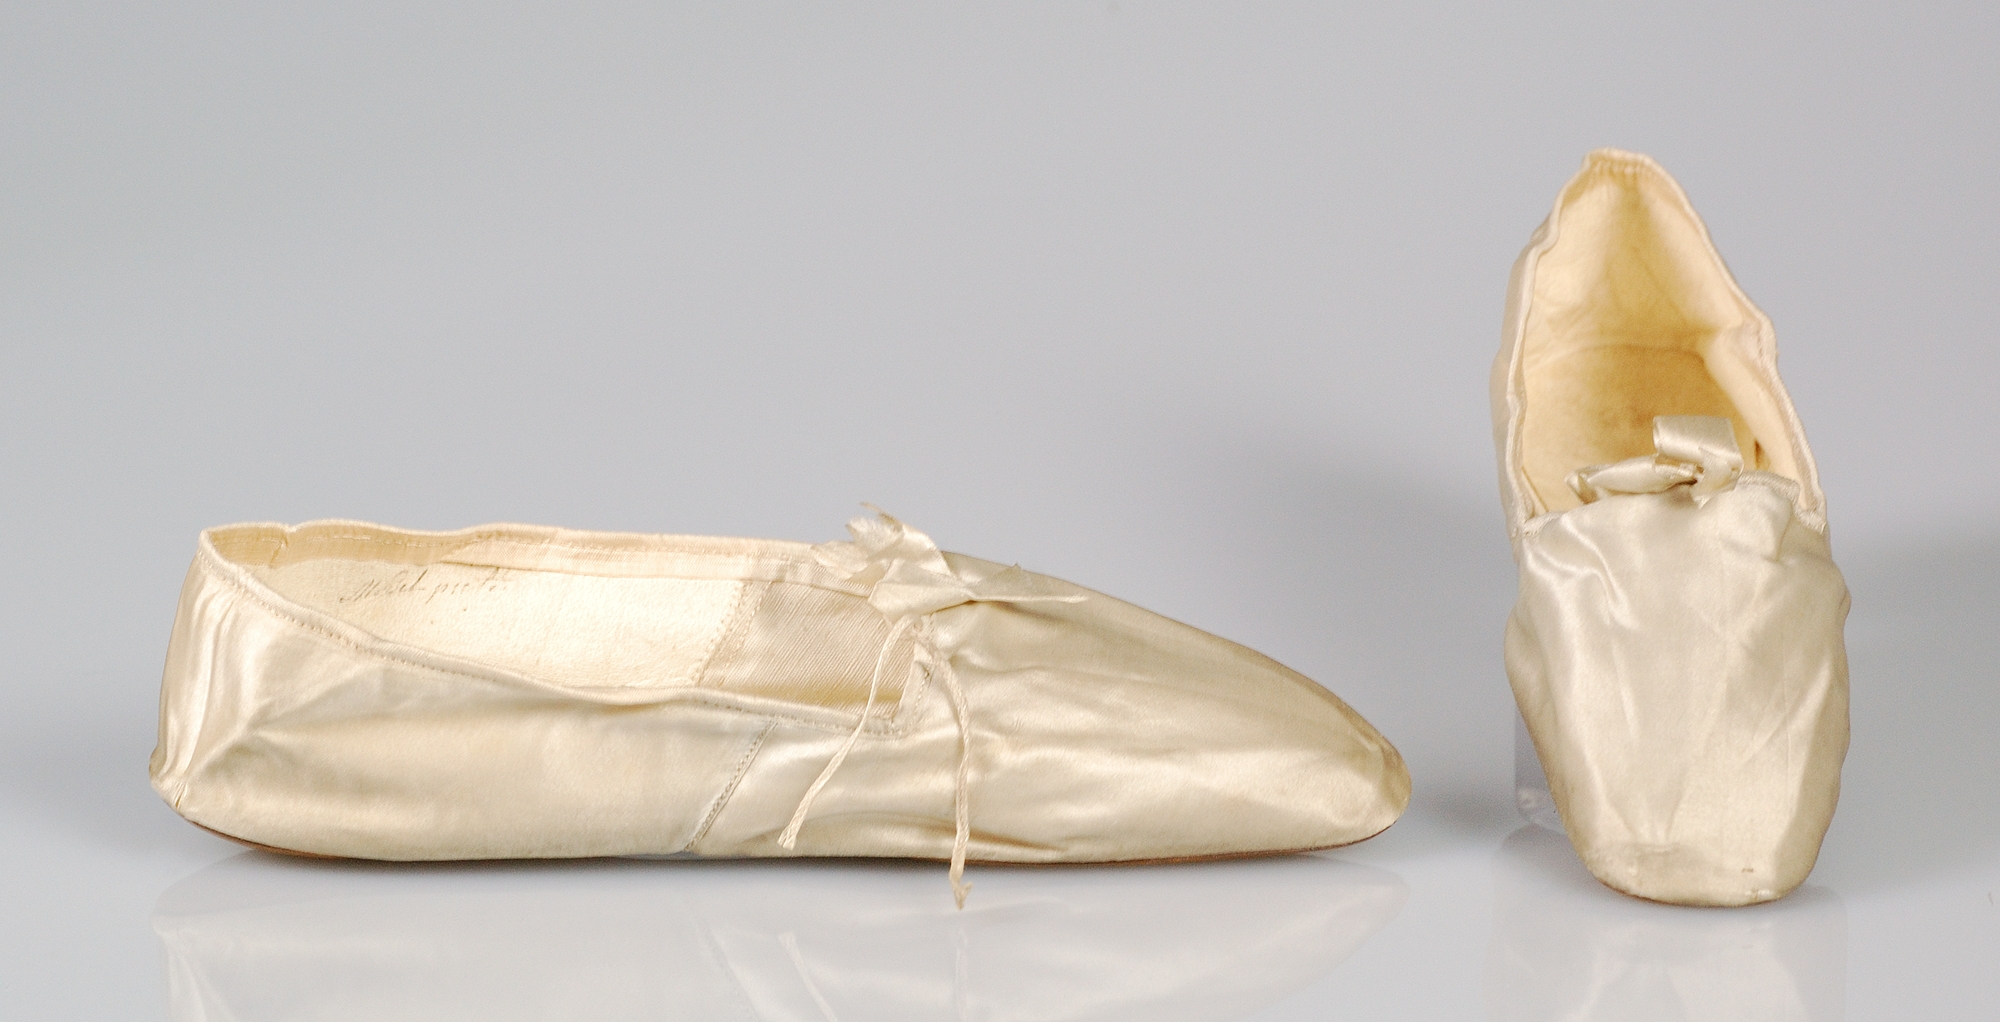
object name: evening slipper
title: Evening slippers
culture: french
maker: p. rouillier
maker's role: maker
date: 1845-1865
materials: silk